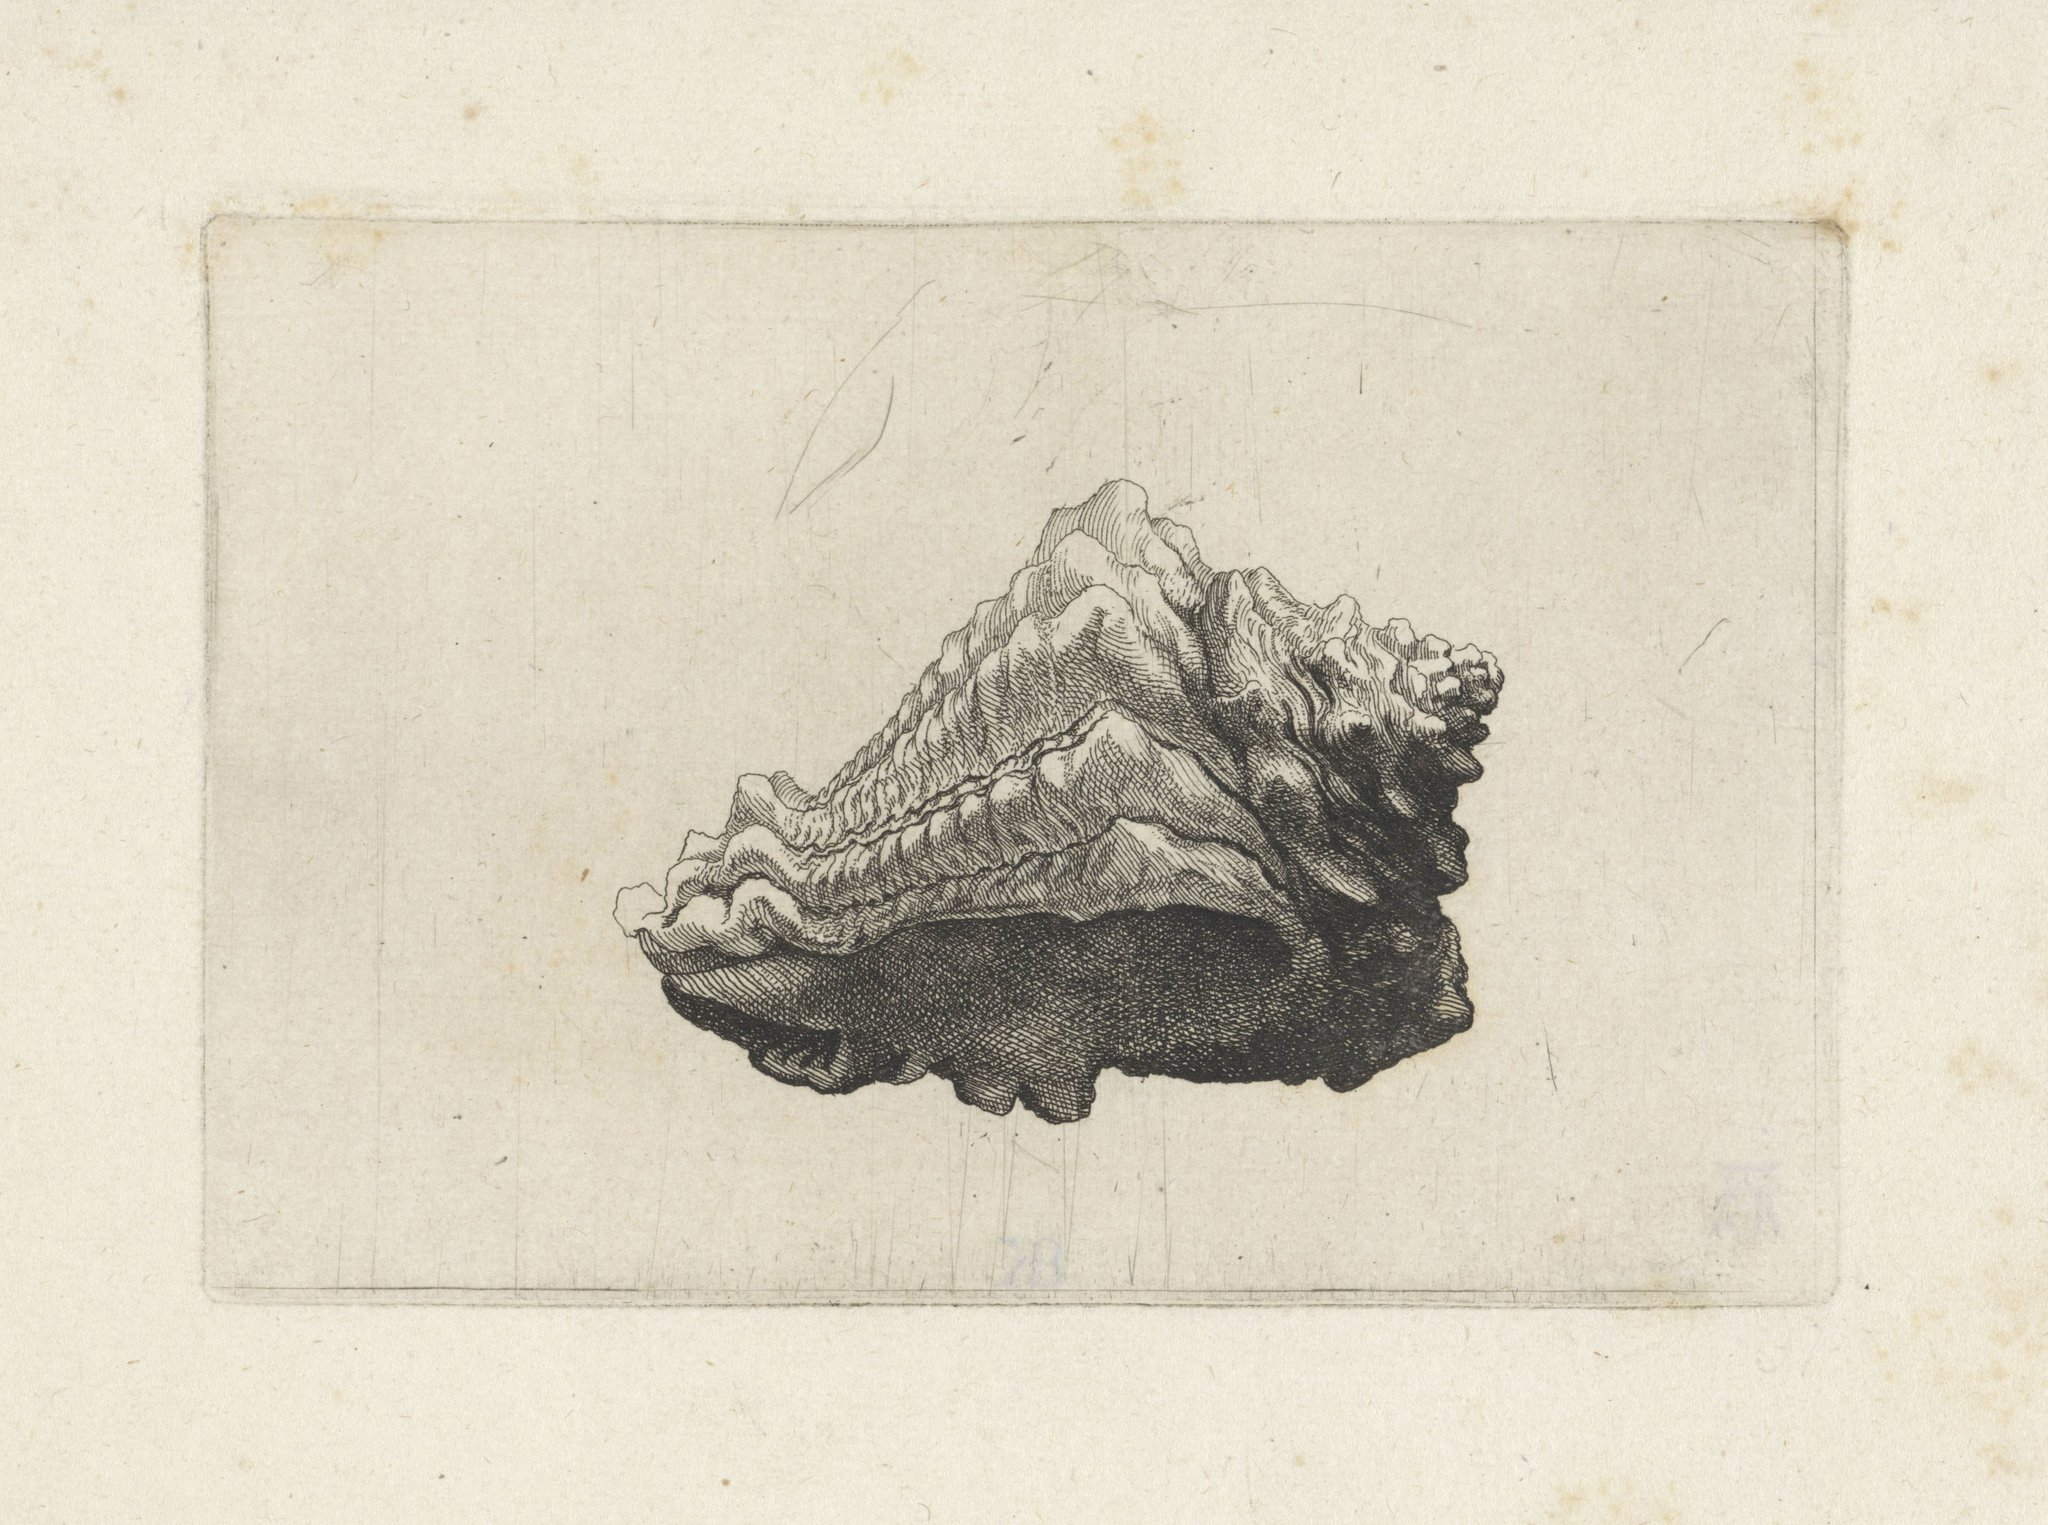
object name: print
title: Schelpen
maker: wenceslaus hollar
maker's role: draughtsman, print maker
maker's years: 1607-1677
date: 1644-1652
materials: paper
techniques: etching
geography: antwerp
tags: molluscs (+ shell, snail-shell etc.)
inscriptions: collector's mark: Lugt 654, collector's mark: Lugt 384, collector's mark: Lugt 68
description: Prent maakt deel uit van een 39-delige serie met verschillende soorten schelpen.